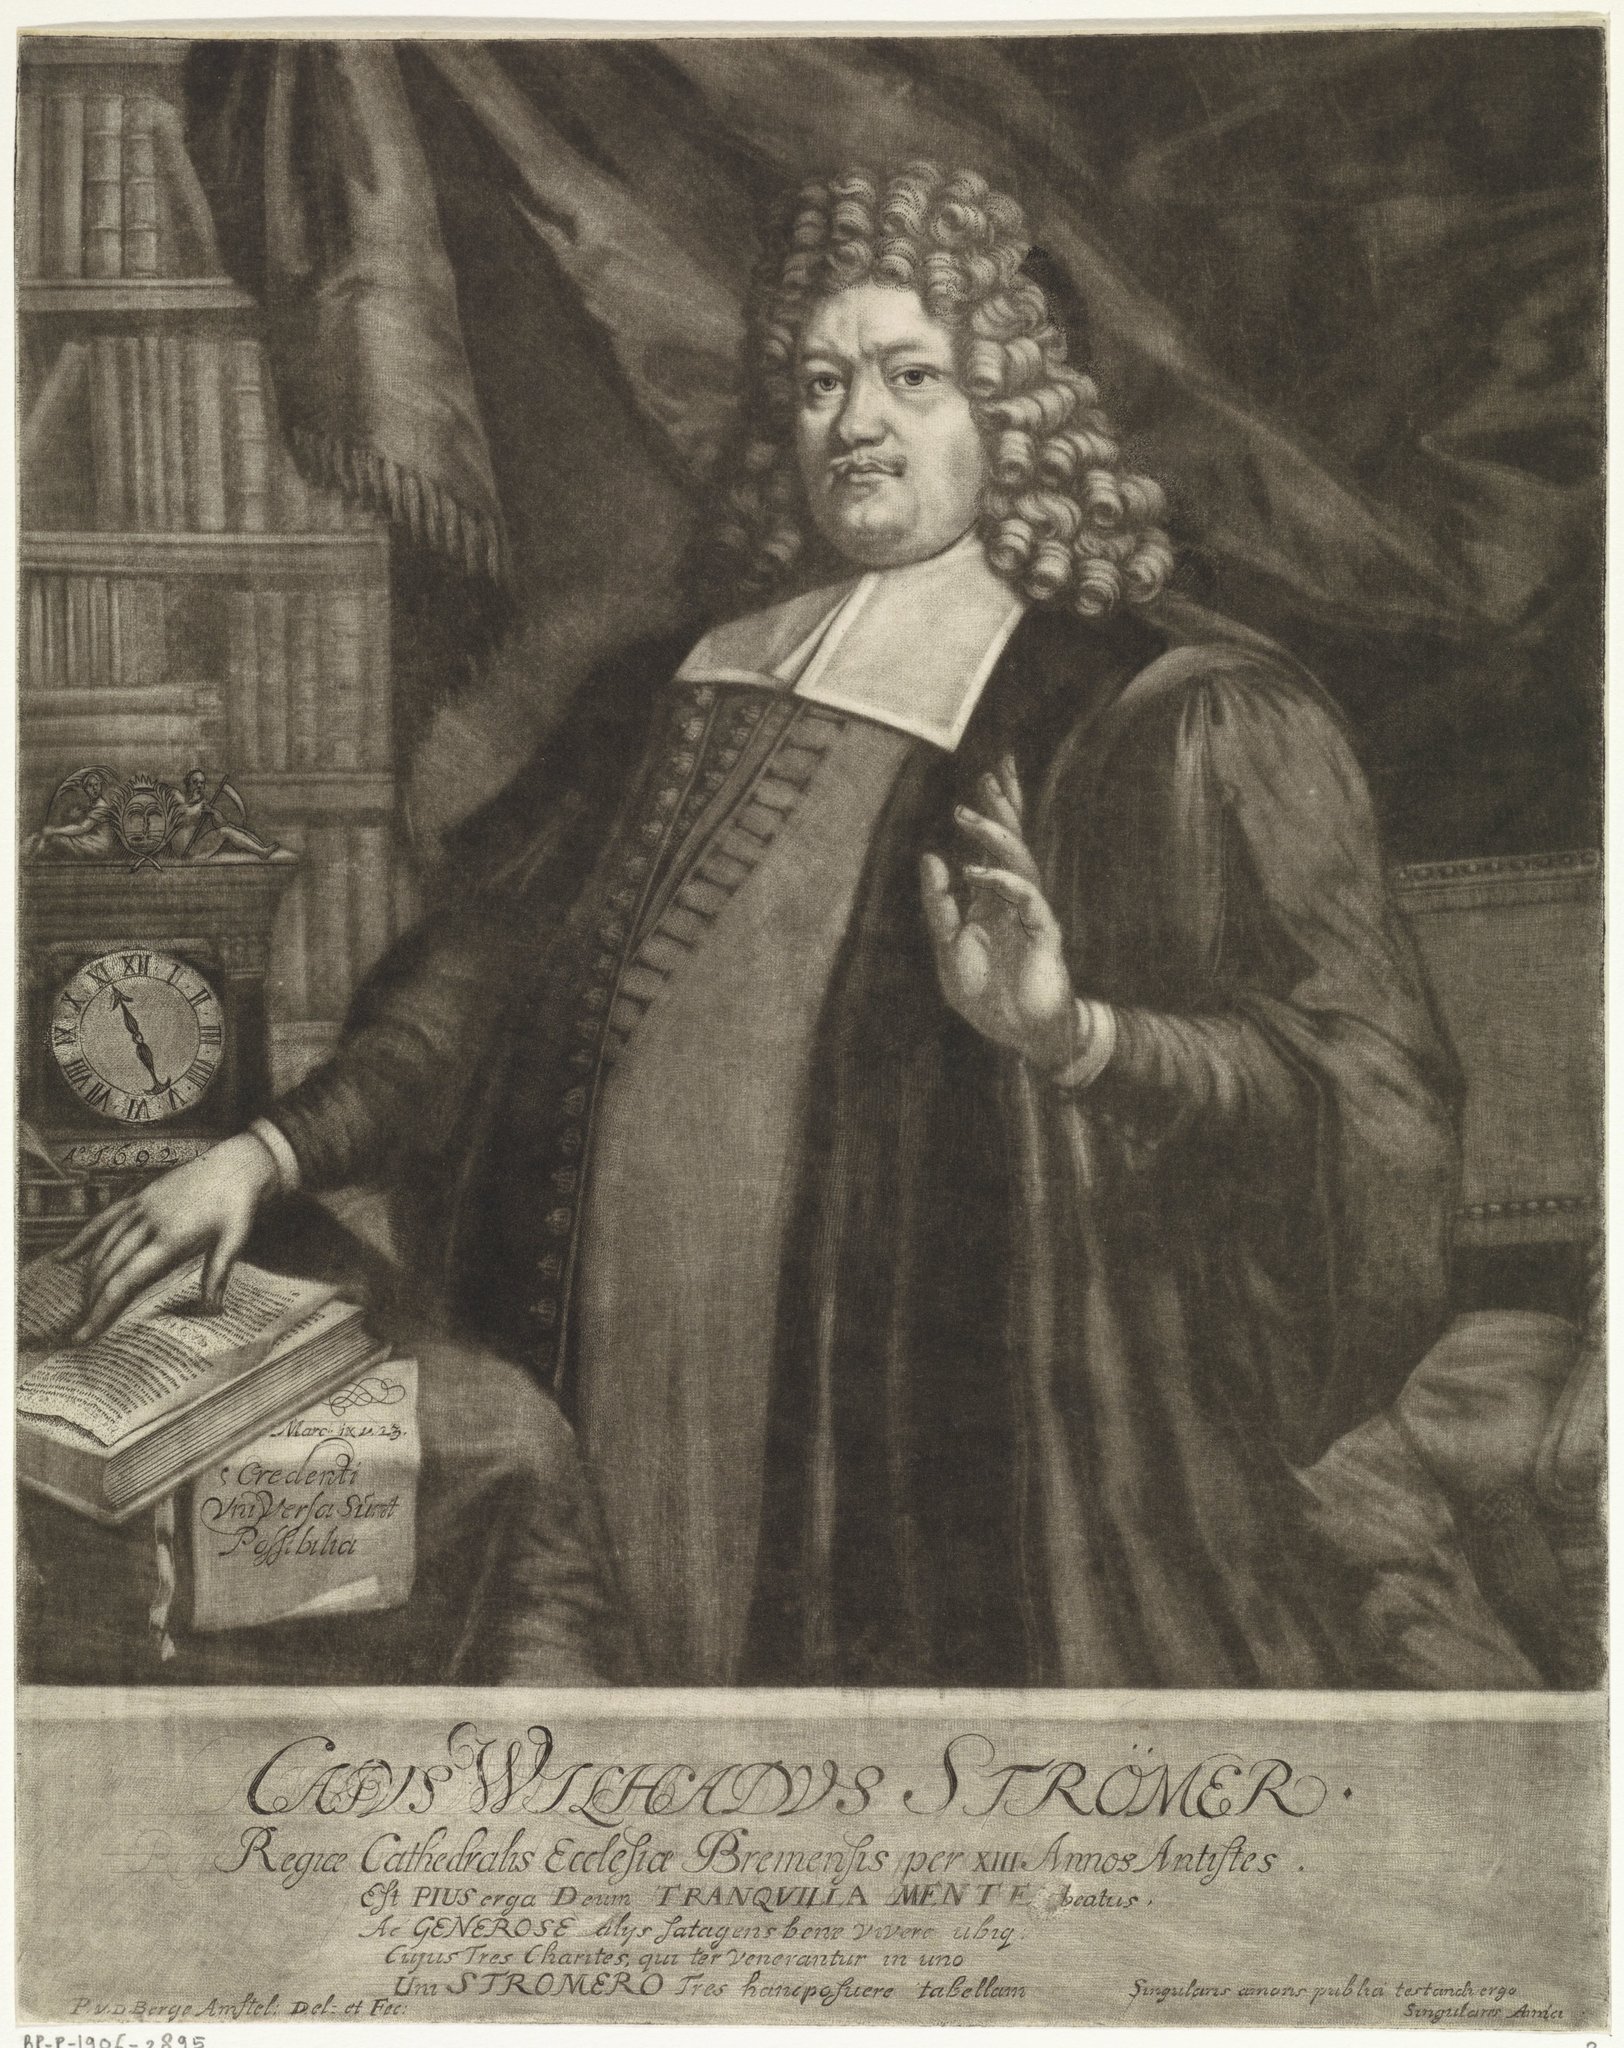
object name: print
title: Portret van Caius Wilhadus Strömer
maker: pieter van den berge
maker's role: draughtsman, print maker, printer, publisher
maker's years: 1659-1737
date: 1692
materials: paper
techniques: engraving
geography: hamburg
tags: study; 'studiolo'; library, book, clock, wig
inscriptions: collector's mark: Lugt 2228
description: Portret van Caius Wilhadus Strömer in zijn studeervertrek. Hij staat aan zijn bureau waarop een klok staat en houdt zijn hand op een opegeslagen boek.